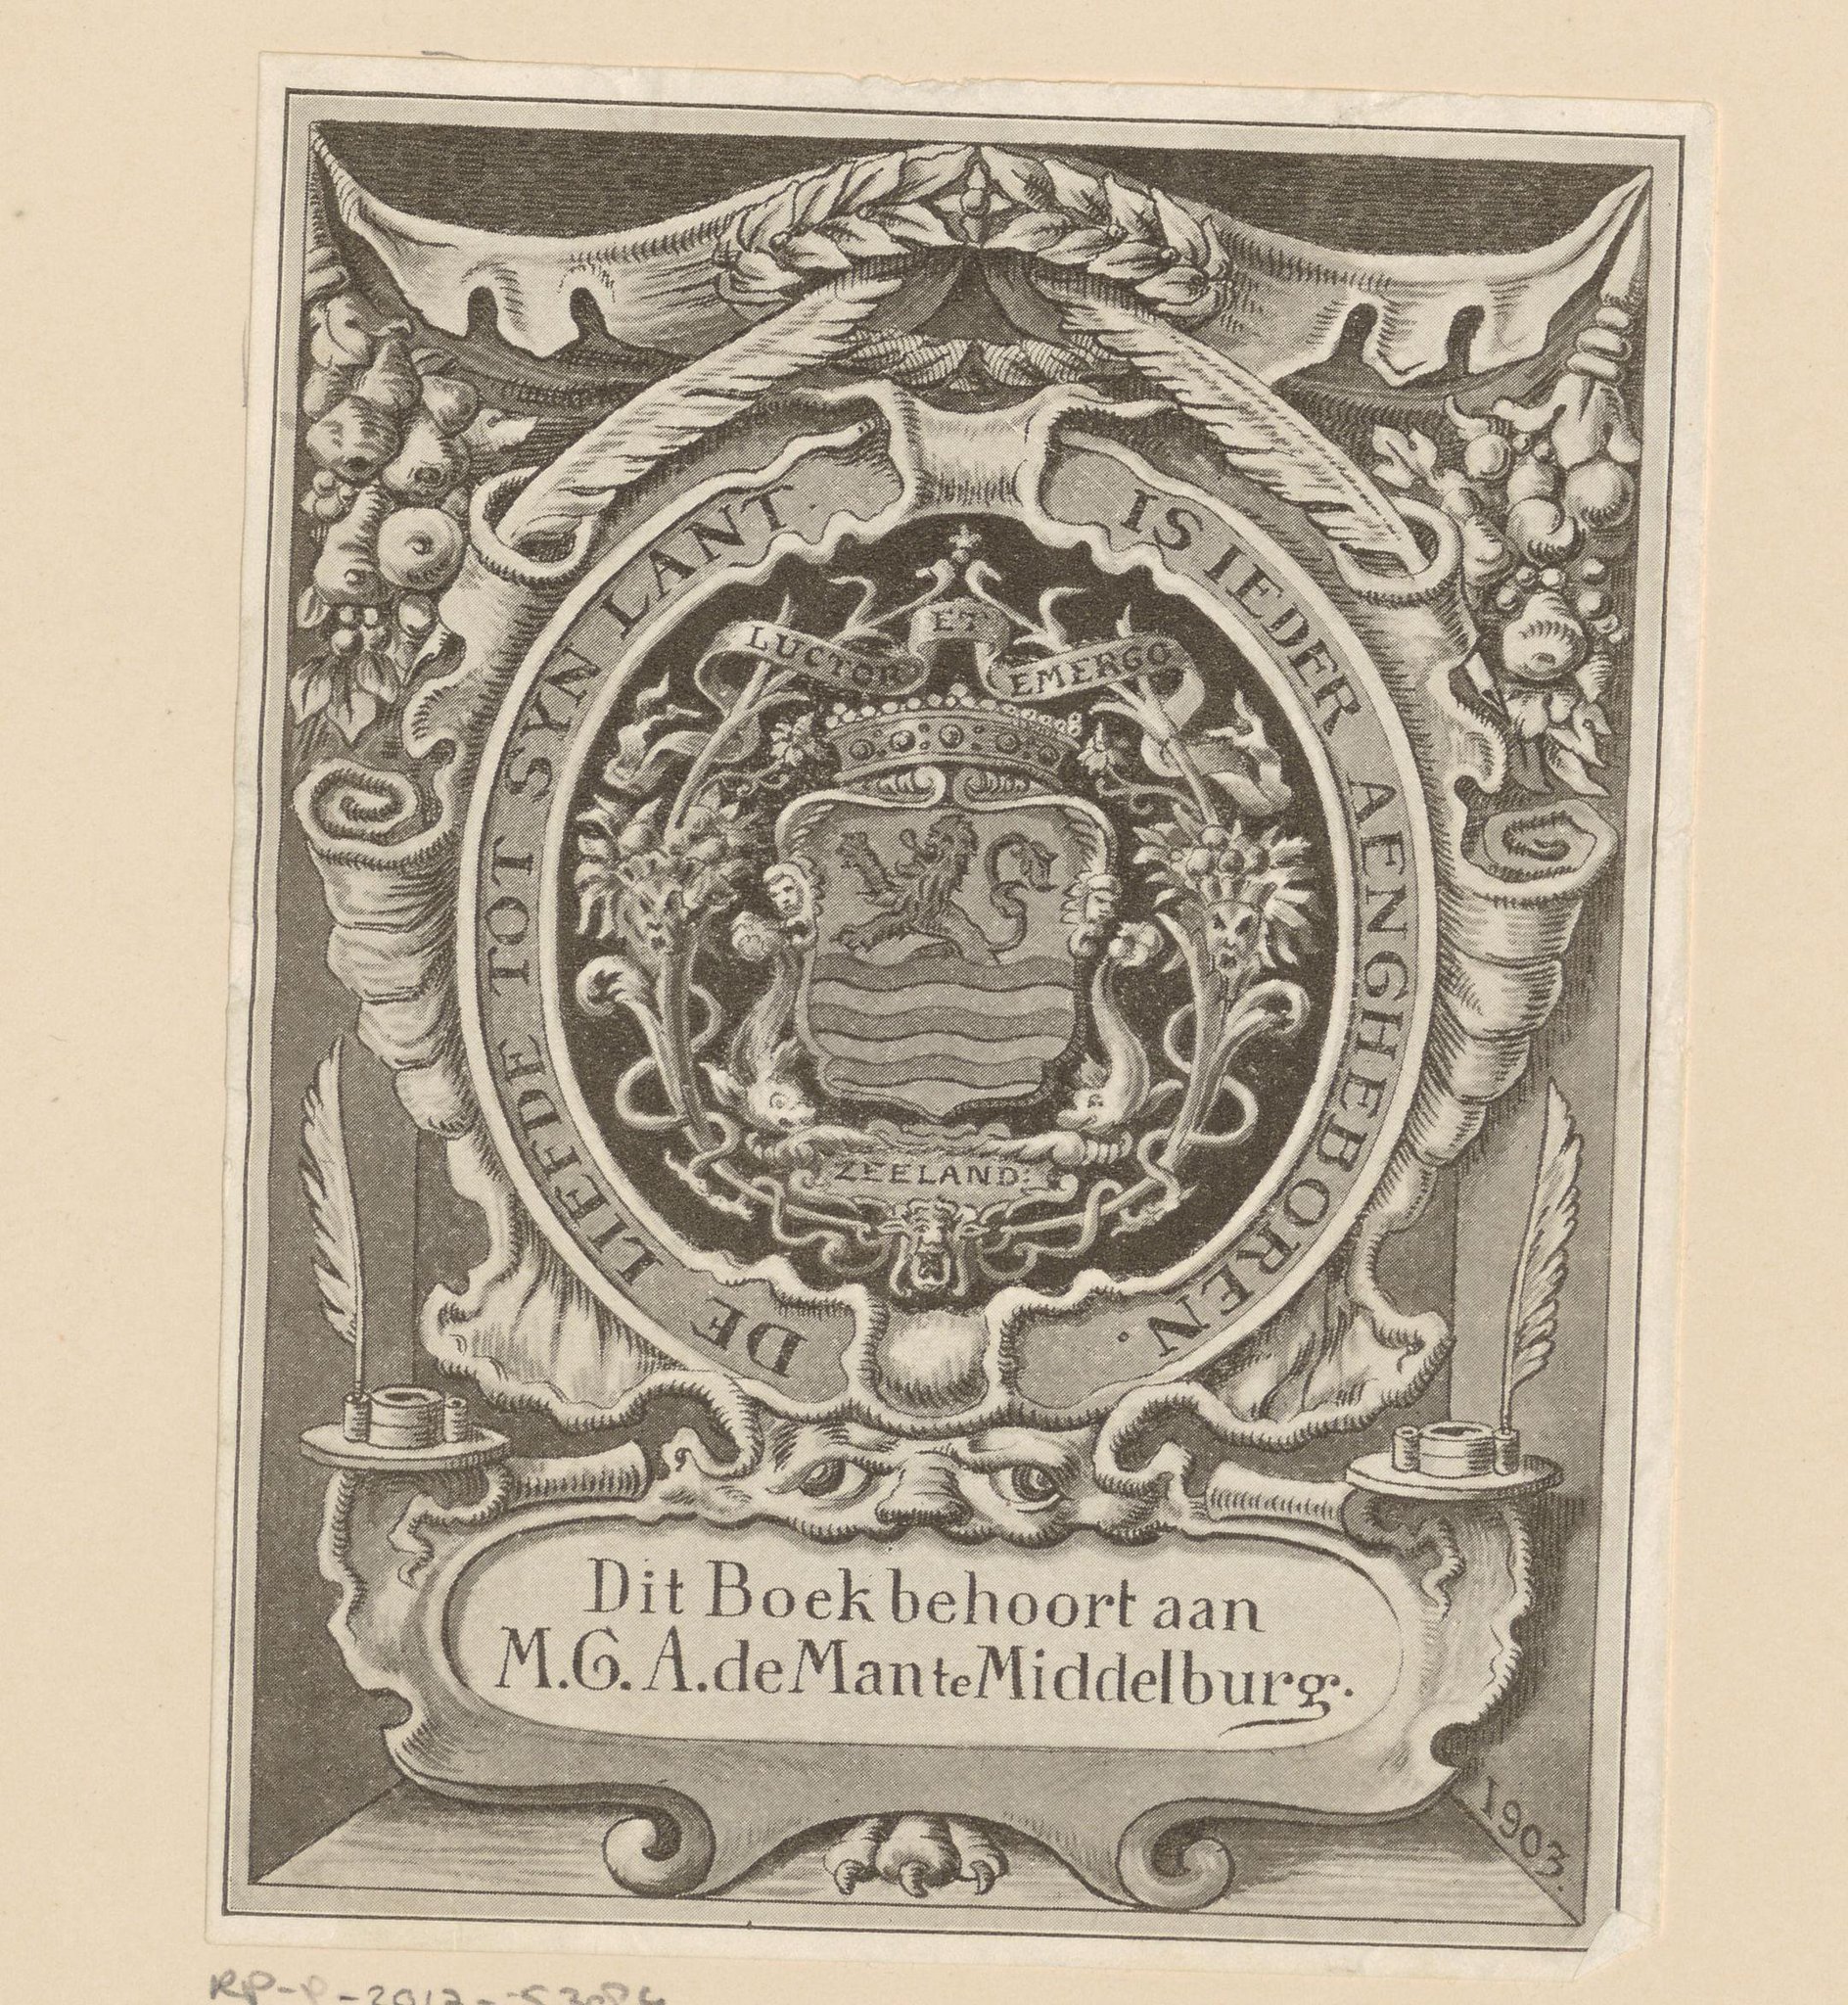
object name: photomechanical print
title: De liefde tot syn lant is ieder aengheboren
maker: Anonymous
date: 1903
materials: paper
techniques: autotype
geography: netherlands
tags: quill, armorial bearing, heraldry, zeeland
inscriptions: date